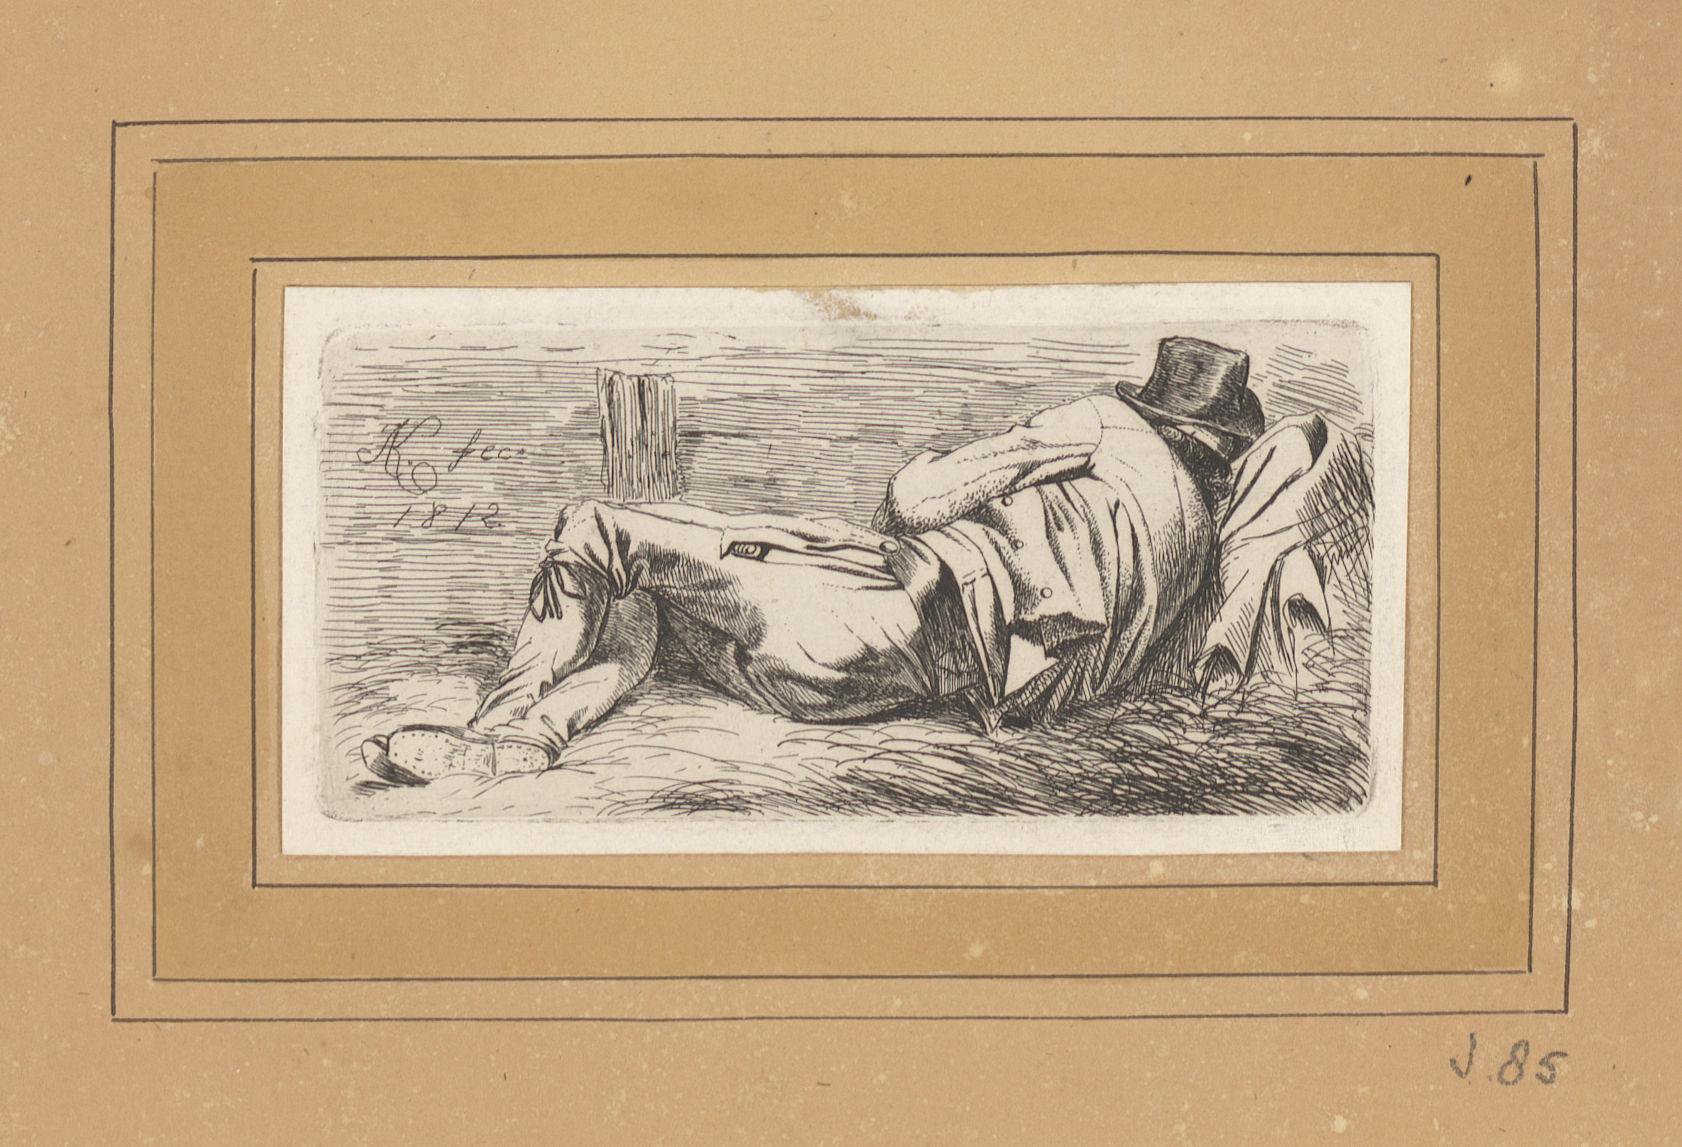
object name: album leaf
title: Slapende man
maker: johann adam klein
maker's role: draughtsman, print maker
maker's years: 1792-1875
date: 1812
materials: paper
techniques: etching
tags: sleeping; unconsciousness, head-gear: top hat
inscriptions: collector's mark: Lugt 2760, collector's mark: Lugt 2228